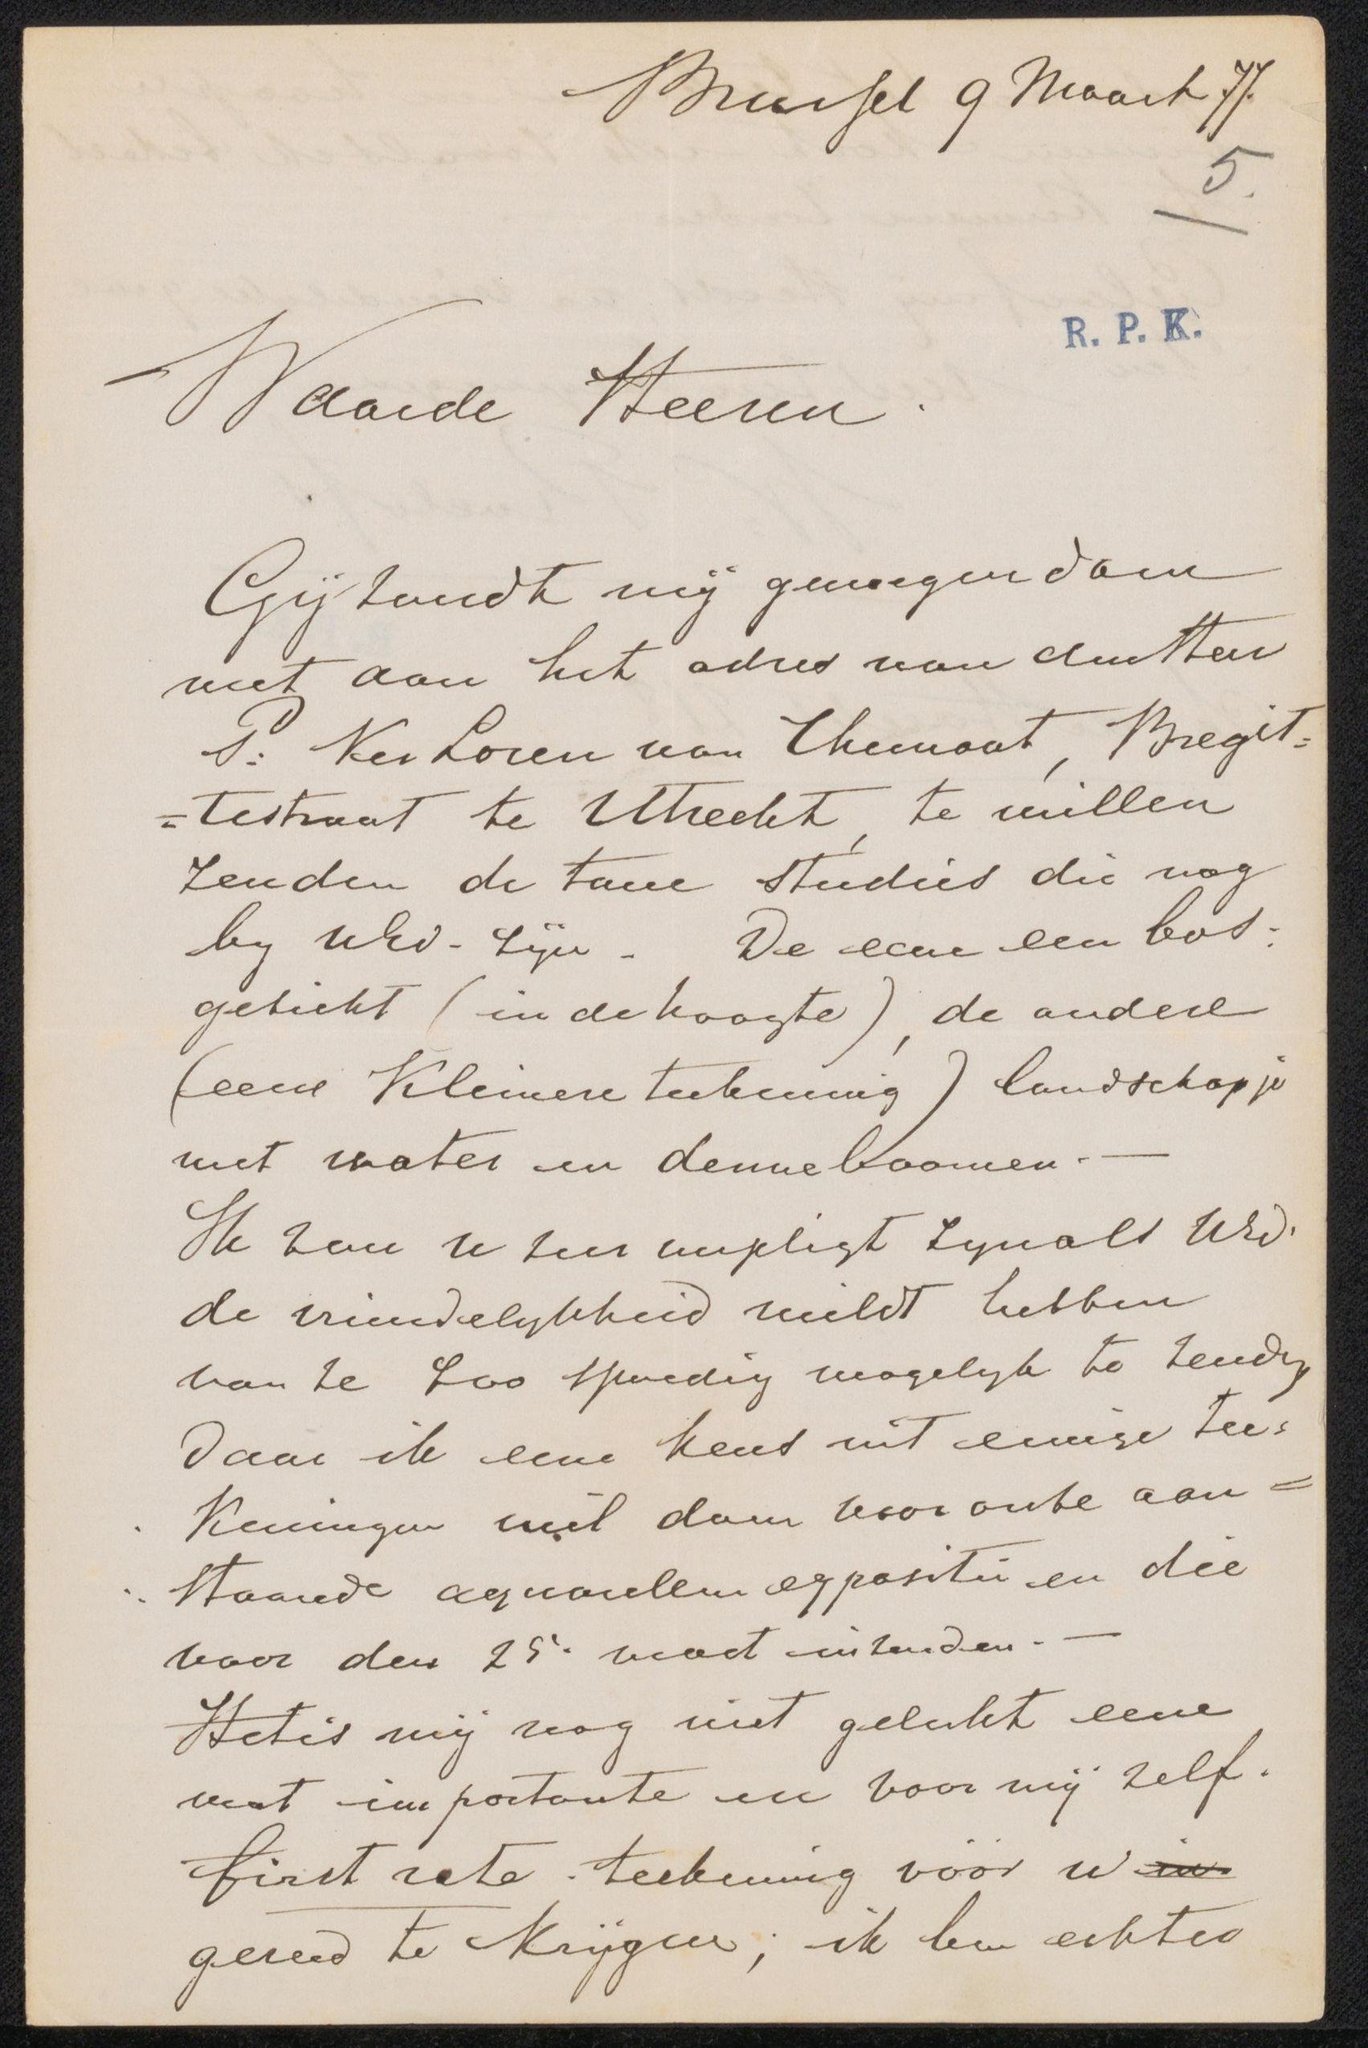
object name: letter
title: Brief aan Frans Buffa en Zonen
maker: willem roelofs (i)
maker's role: draughtsman, painter, print maker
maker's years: 1822-1897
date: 1877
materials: ink, paper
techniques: pen, writing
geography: brussels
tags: utrecht, pieter verloren van themaat, publisher, art trade, art shop, drawing, exhibition ~ art, money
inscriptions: collector's mark: Lugt 2233